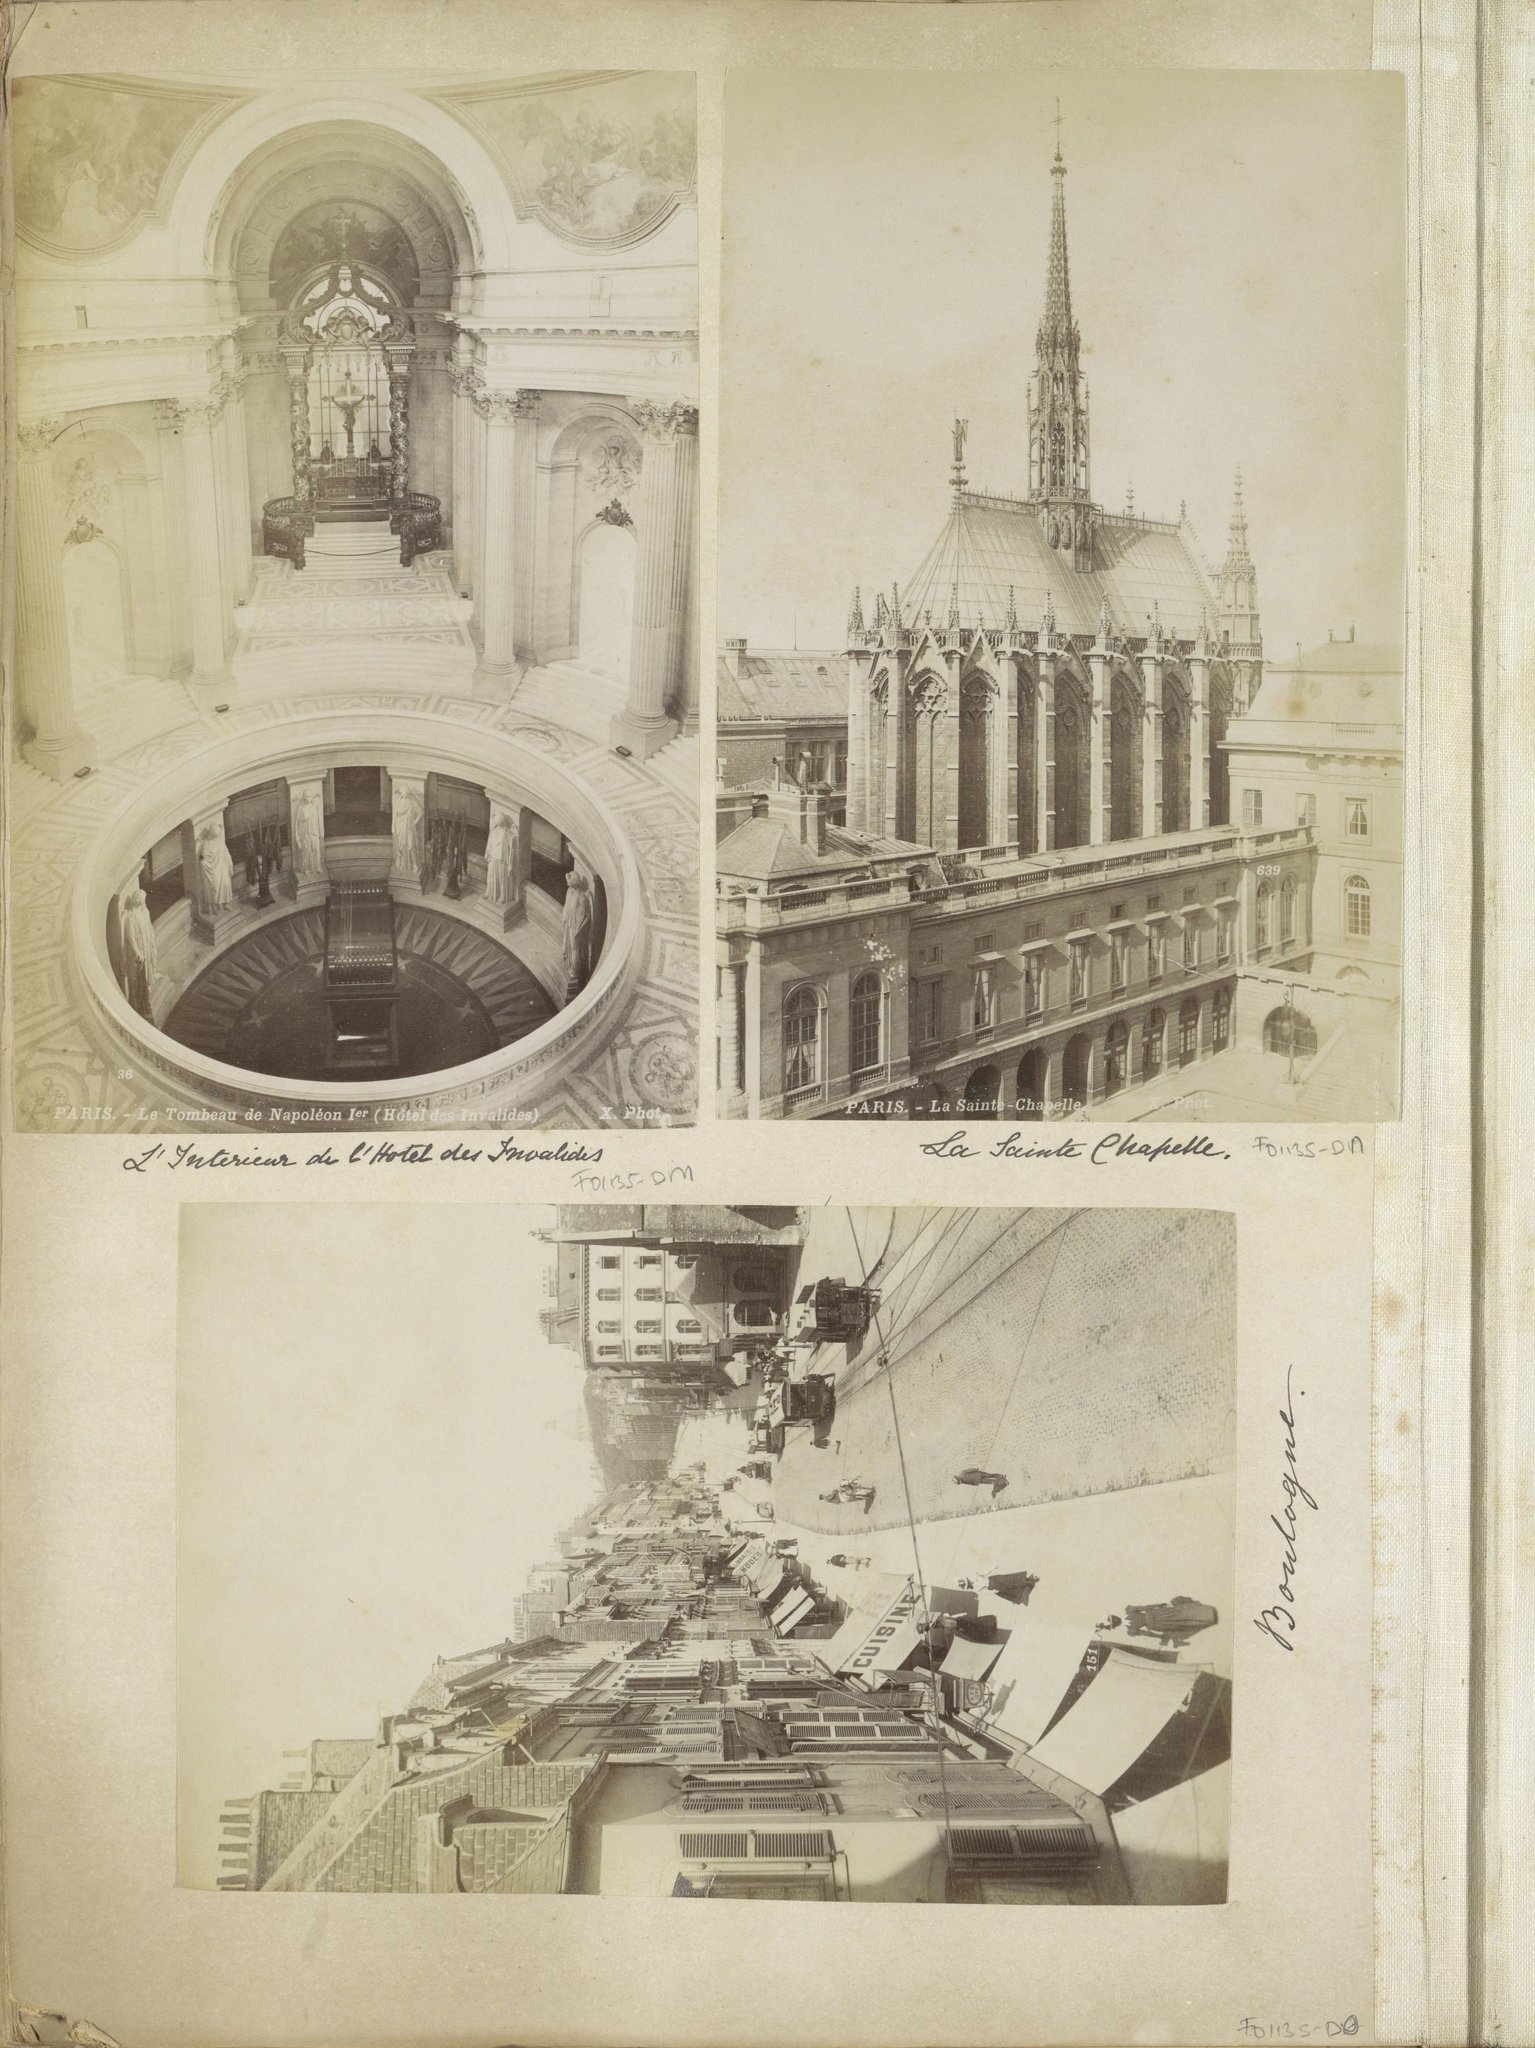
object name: photograph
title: Paris - Le Tombeau de Napoléon Ier (Hôtel des Invalides)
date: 1901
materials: paper, photographic support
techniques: albumen print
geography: dome of the invalides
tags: grave, tomb, parts of church interior: chapel, paris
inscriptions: negative number: ‘36’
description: Onderdeel van Reisalbum met foto's van bezienswaardigheden in Engeland en Frankrijk.